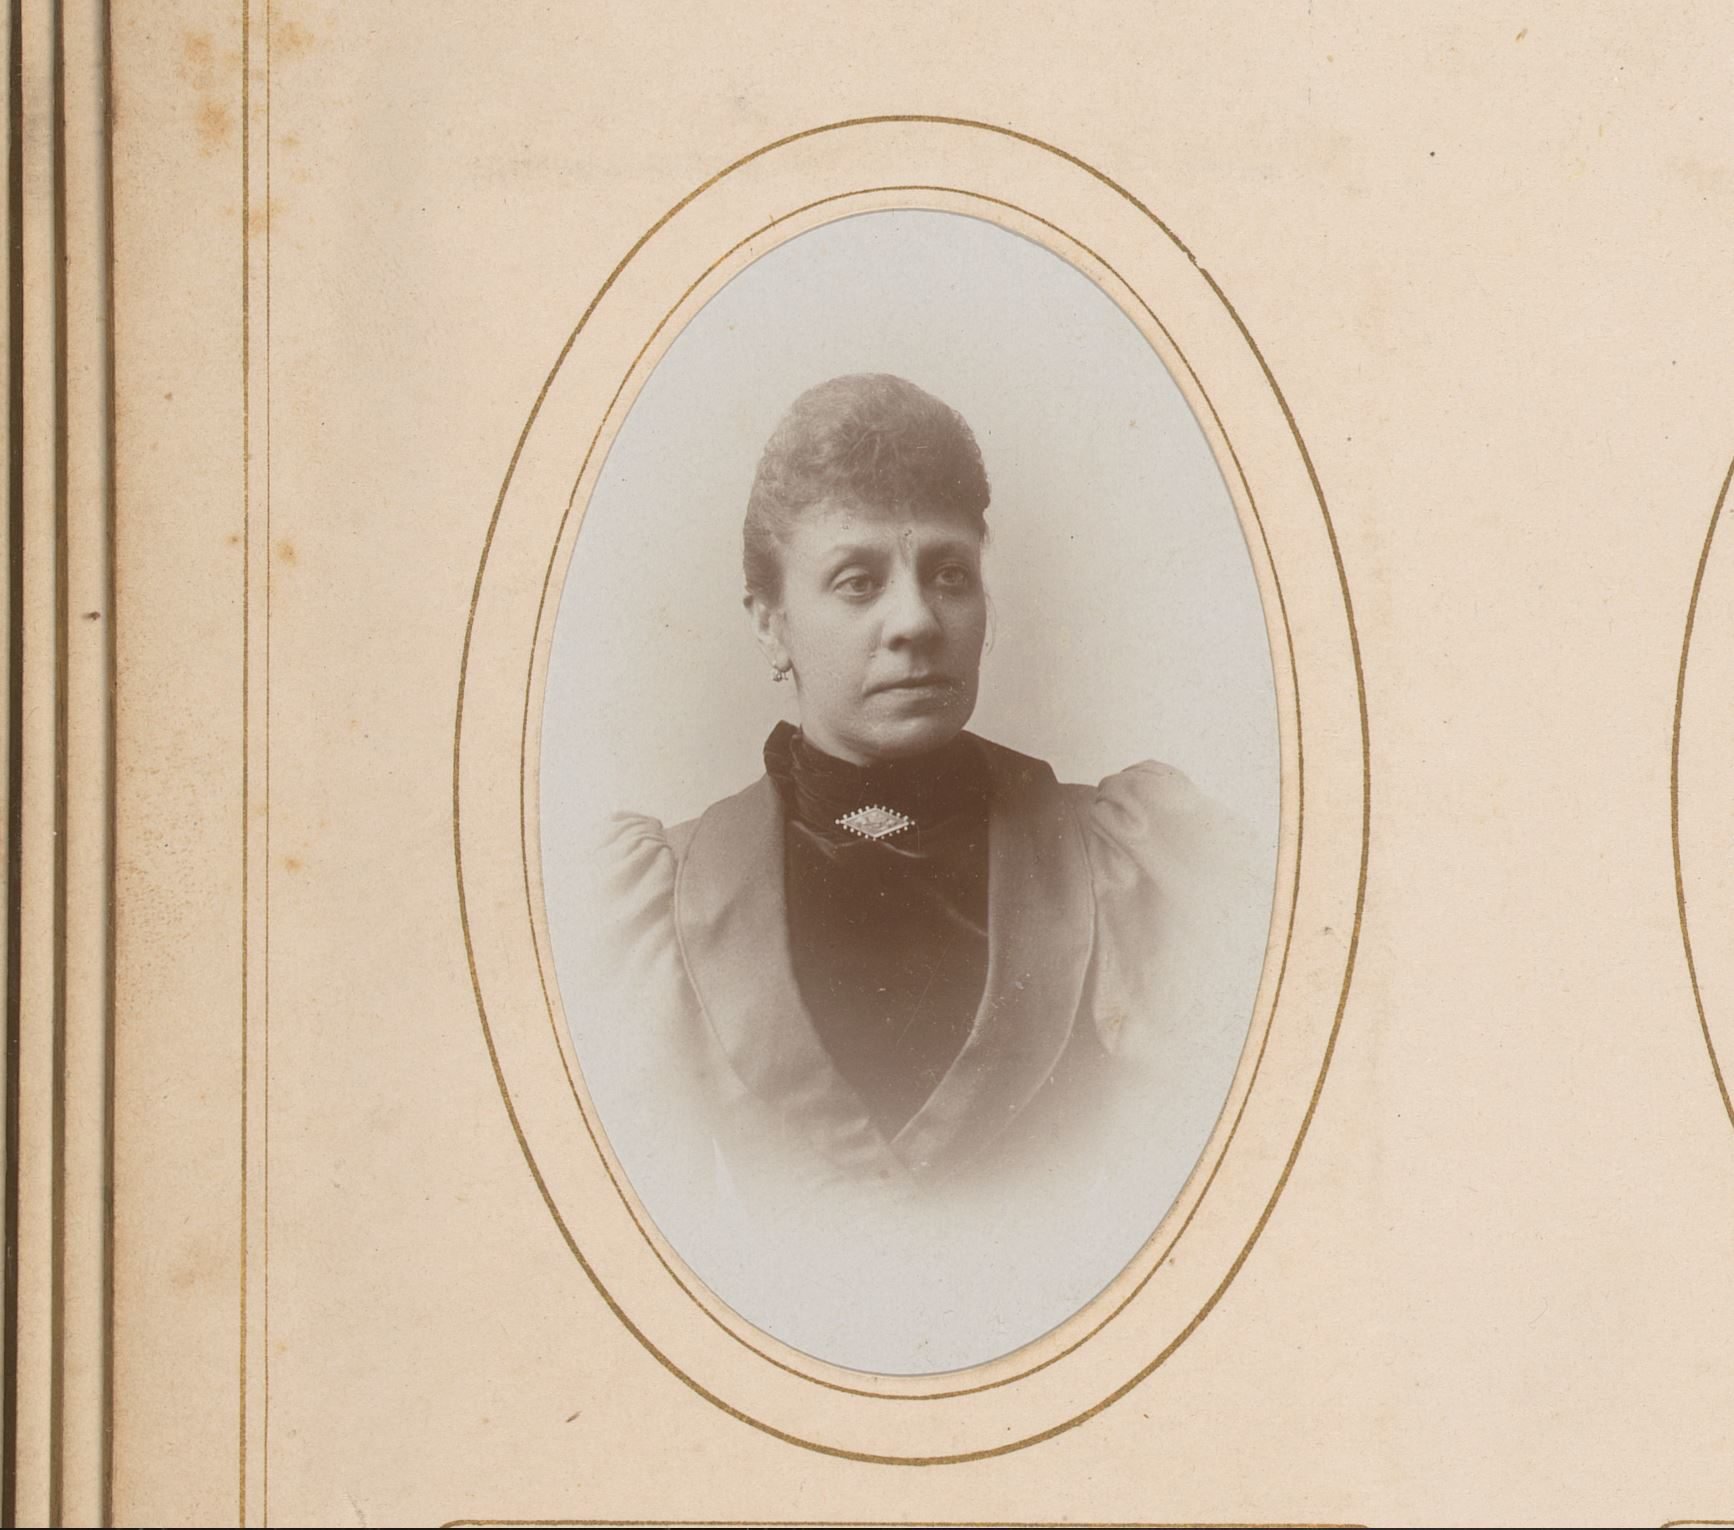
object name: photograph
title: Portret van een vrouw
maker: cornelis johannes lodewicus vermeulen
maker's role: fotograaf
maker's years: 1861-1936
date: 1888-1896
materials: cardboard, photographic support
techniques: collodion silver print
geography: amsterdam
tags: historical persons - bb - woman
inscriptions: inscription: ‘Photographische Ateliers/ C.J.L. Vermeulen/ Heerenstraat 6, Heiligenweg/ hoek Singel/ Amsterdam’